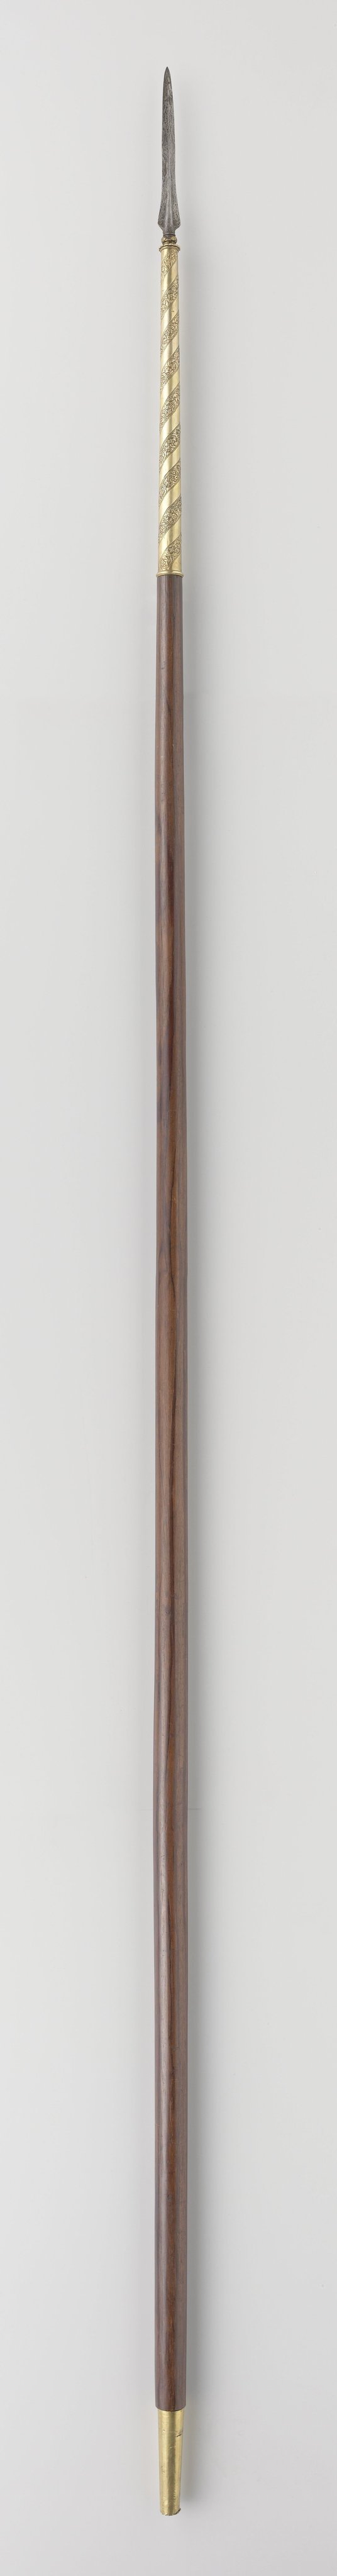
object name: pike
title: Lans van het wapenrek van Gouverneur-Generaal J.C. baron Baud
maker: Anonymous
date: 1800-1900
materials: copper, iron, wood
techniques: printing, cutting, forging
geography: java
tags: the hague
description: Ronde houten schacht met rond de onderzijde een koperen omhulsel. Aan de onderkant is de schacht hol. Aan de bovenzijde van de schacht een koperen omhulsel dat is versierd met spiraalvormig lopende blad- en bloemmotieven. Een smalle kling toelopend in een scherpe punt. De kling is van gewaterd staal.